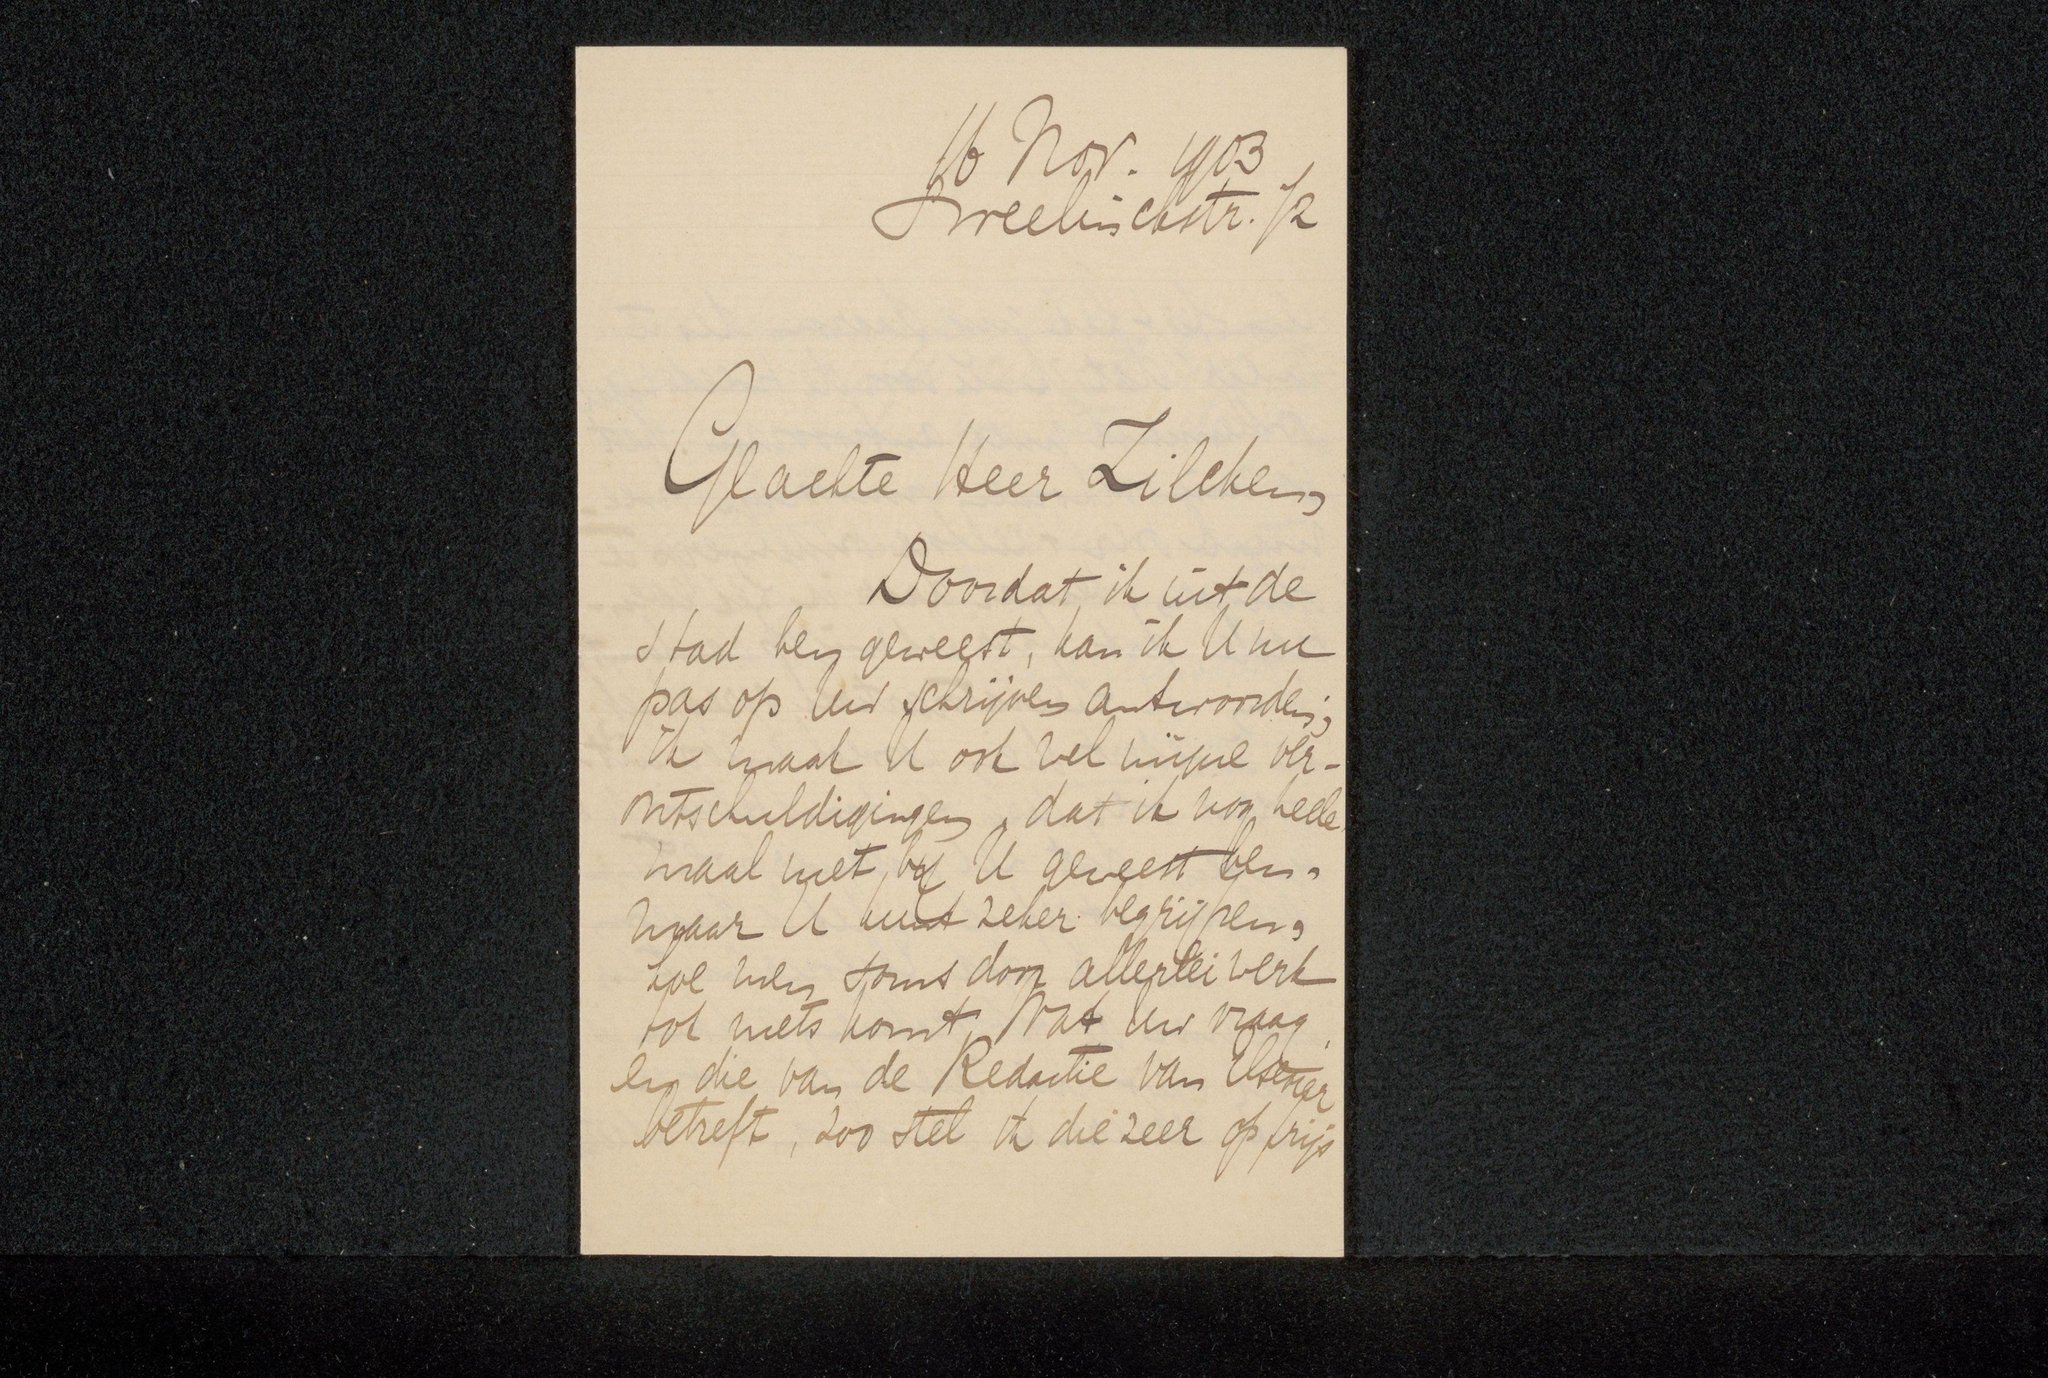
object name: letter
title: Brief aan Philip Zilcken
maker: johanna suzanne goekoop-de jongh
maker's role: kunsthistoricus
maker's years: 1877-1946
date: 1903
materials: ink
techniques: pen, writing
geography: the hague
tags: painter, draughtsman, philip zilcken, photography, cinematography, exhibition ~ art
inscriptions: collector's mark: ‘RPK’